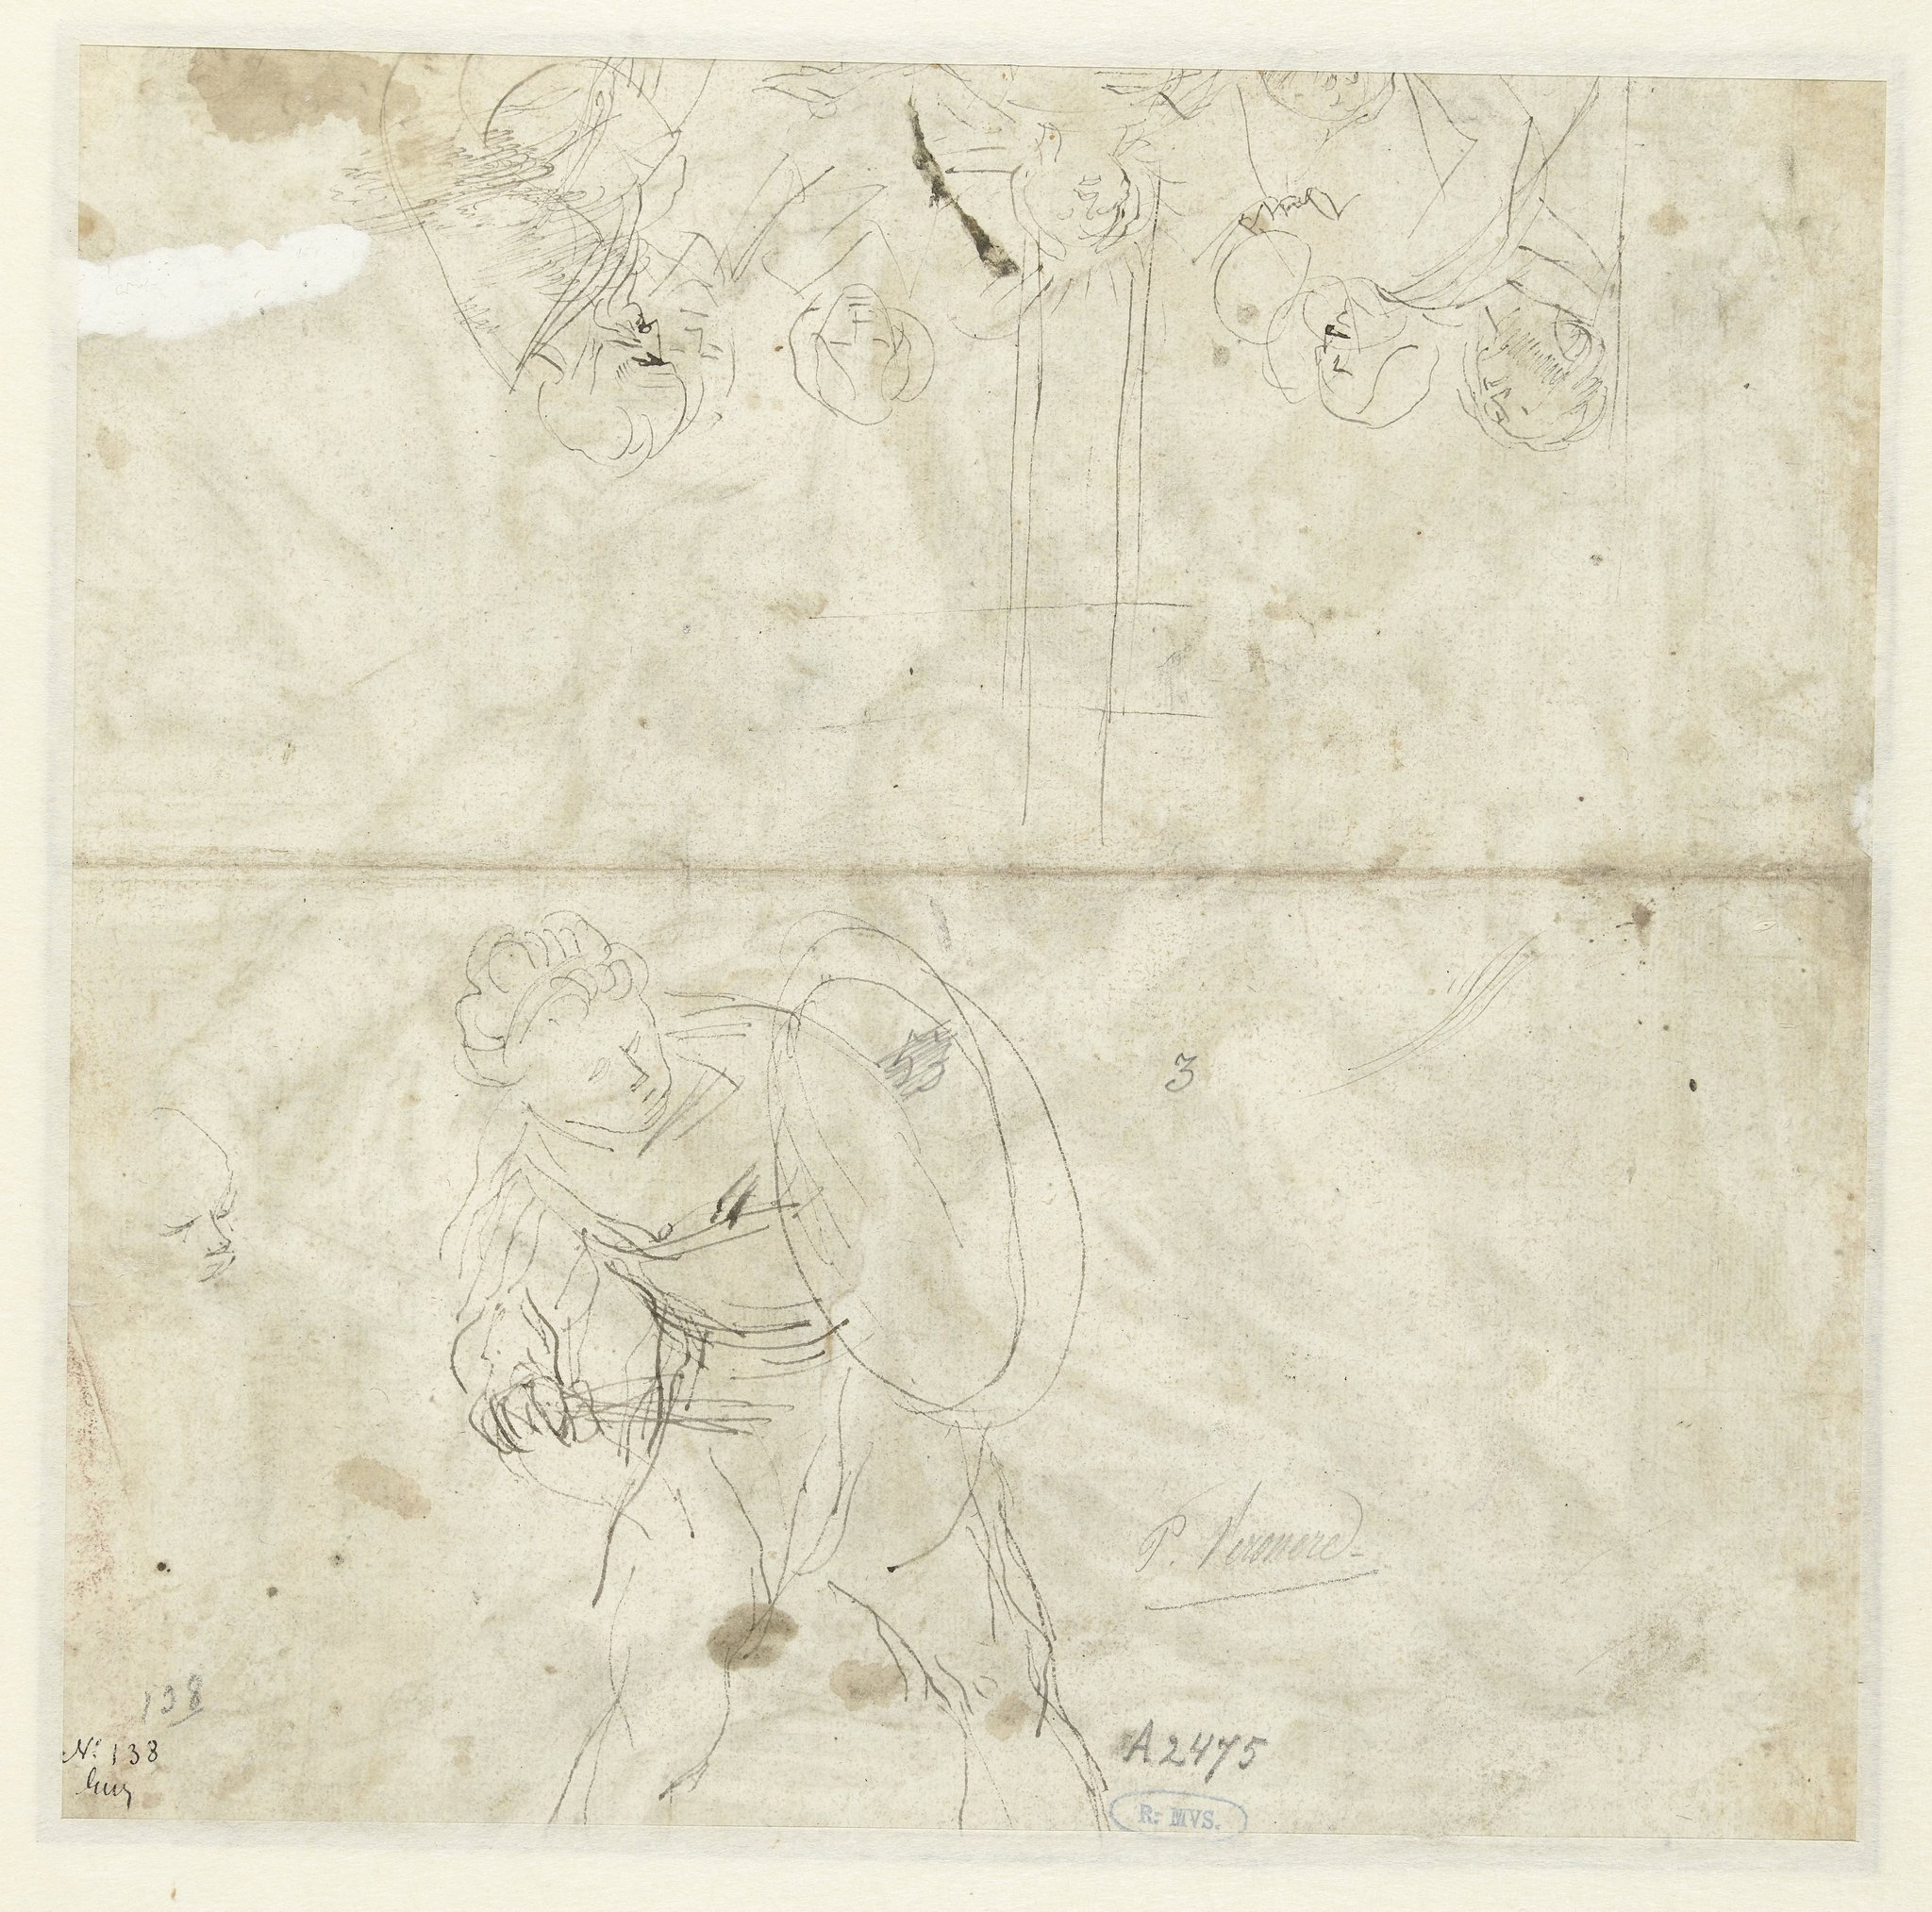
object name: drawing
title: Schetsen van een krijger en een gedeelte van een Kruisafname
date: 1534-1606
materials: ink, paper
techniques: pen